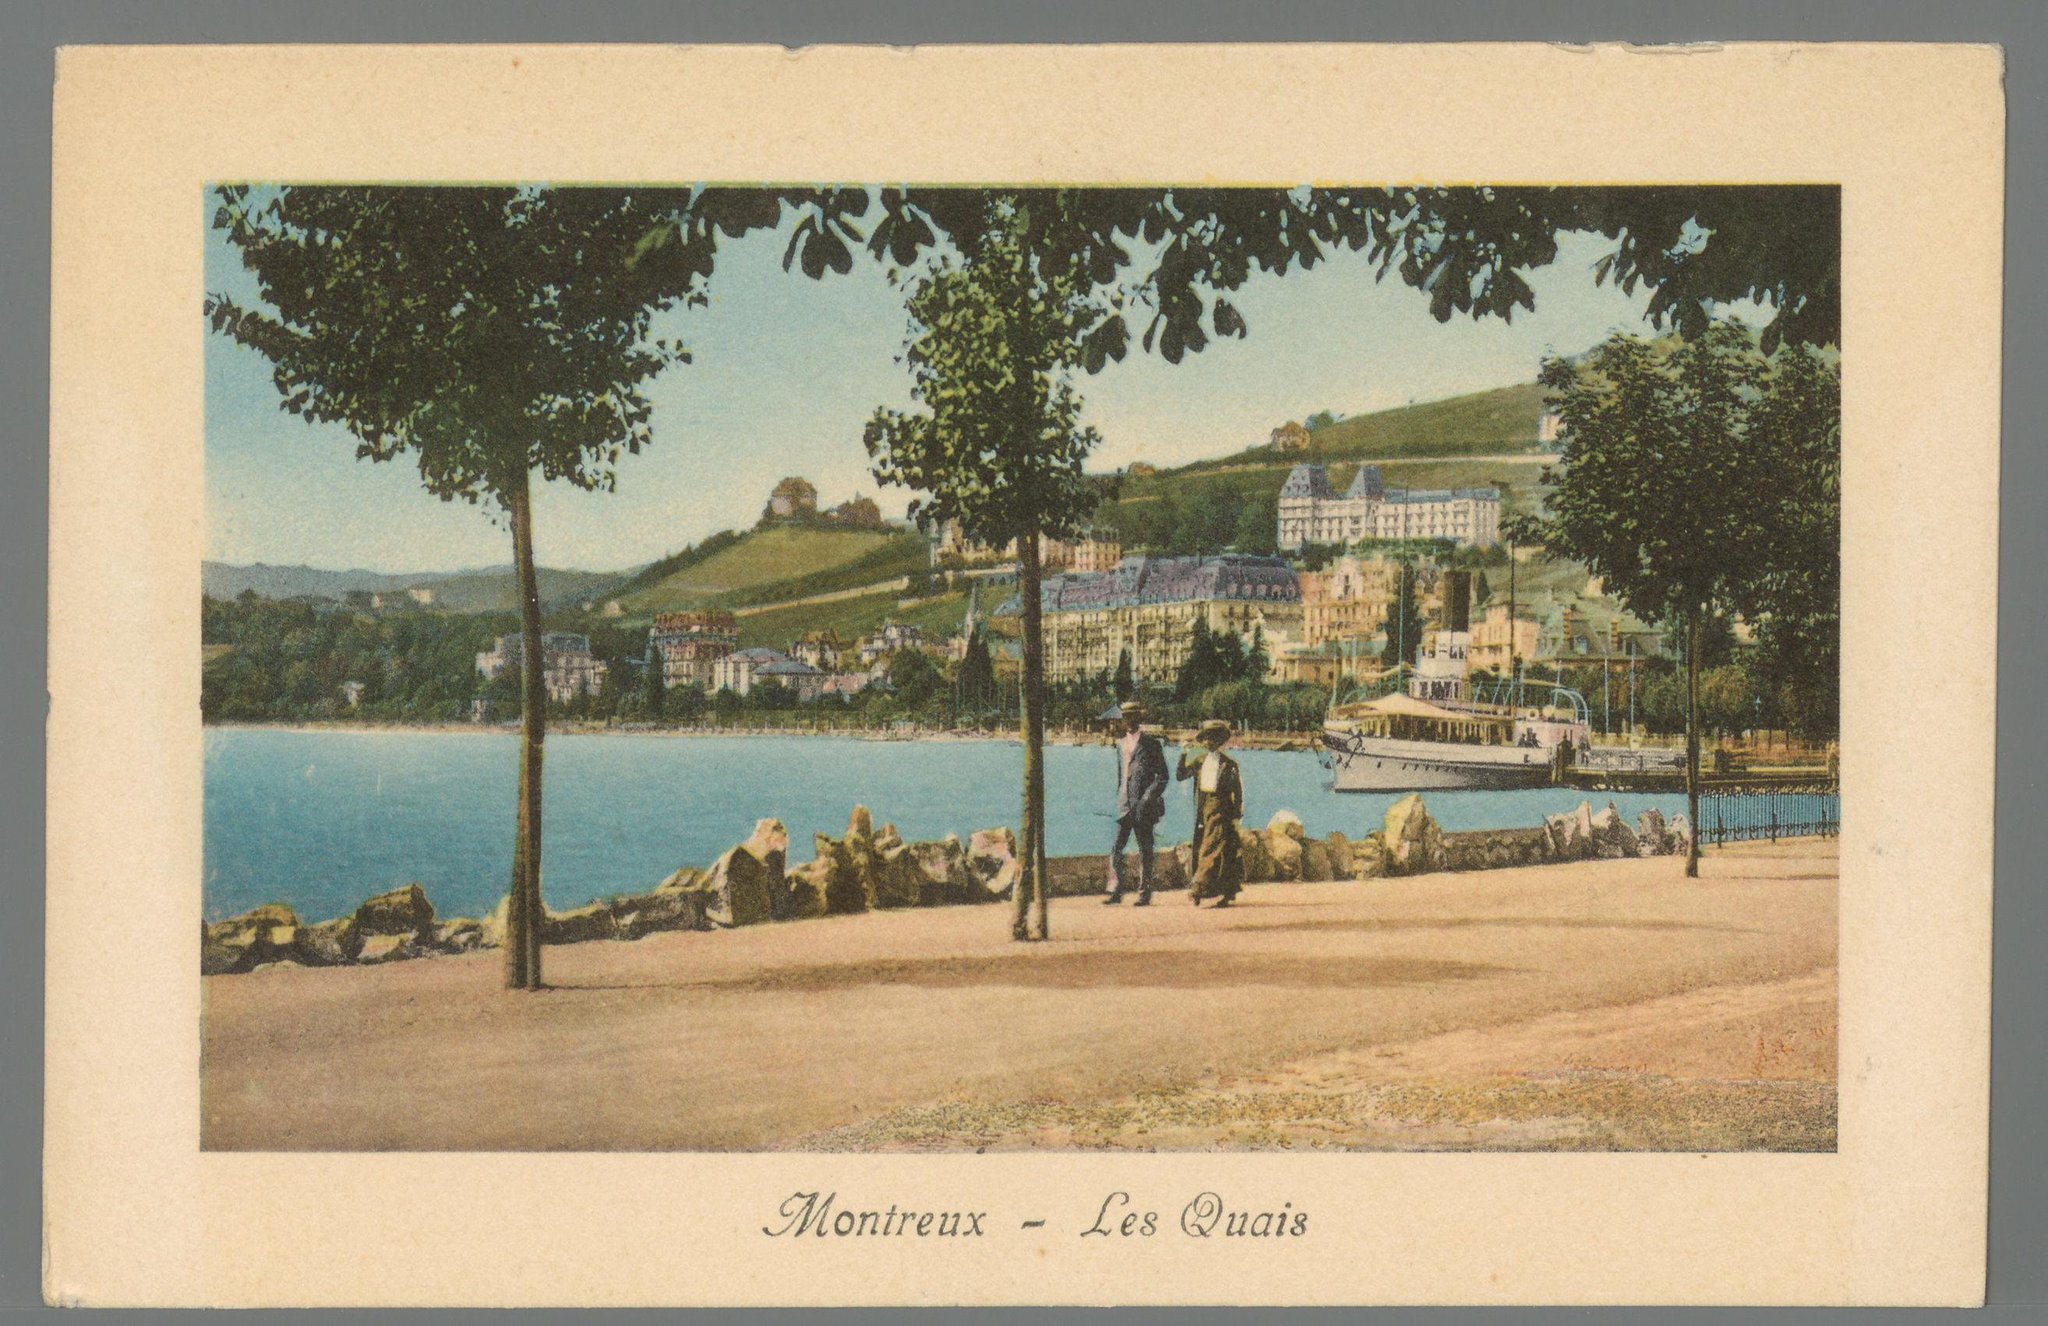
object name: ansichtkaart, prentbriefkaart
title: Montreux. Les Quais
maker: Anonymous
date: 1905-1920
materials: cardboard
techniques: photograph, lithograph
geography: geneva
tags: lake, city-view, and landscape with man-made constructions (+ city(-scape) with figures, staffage), quay